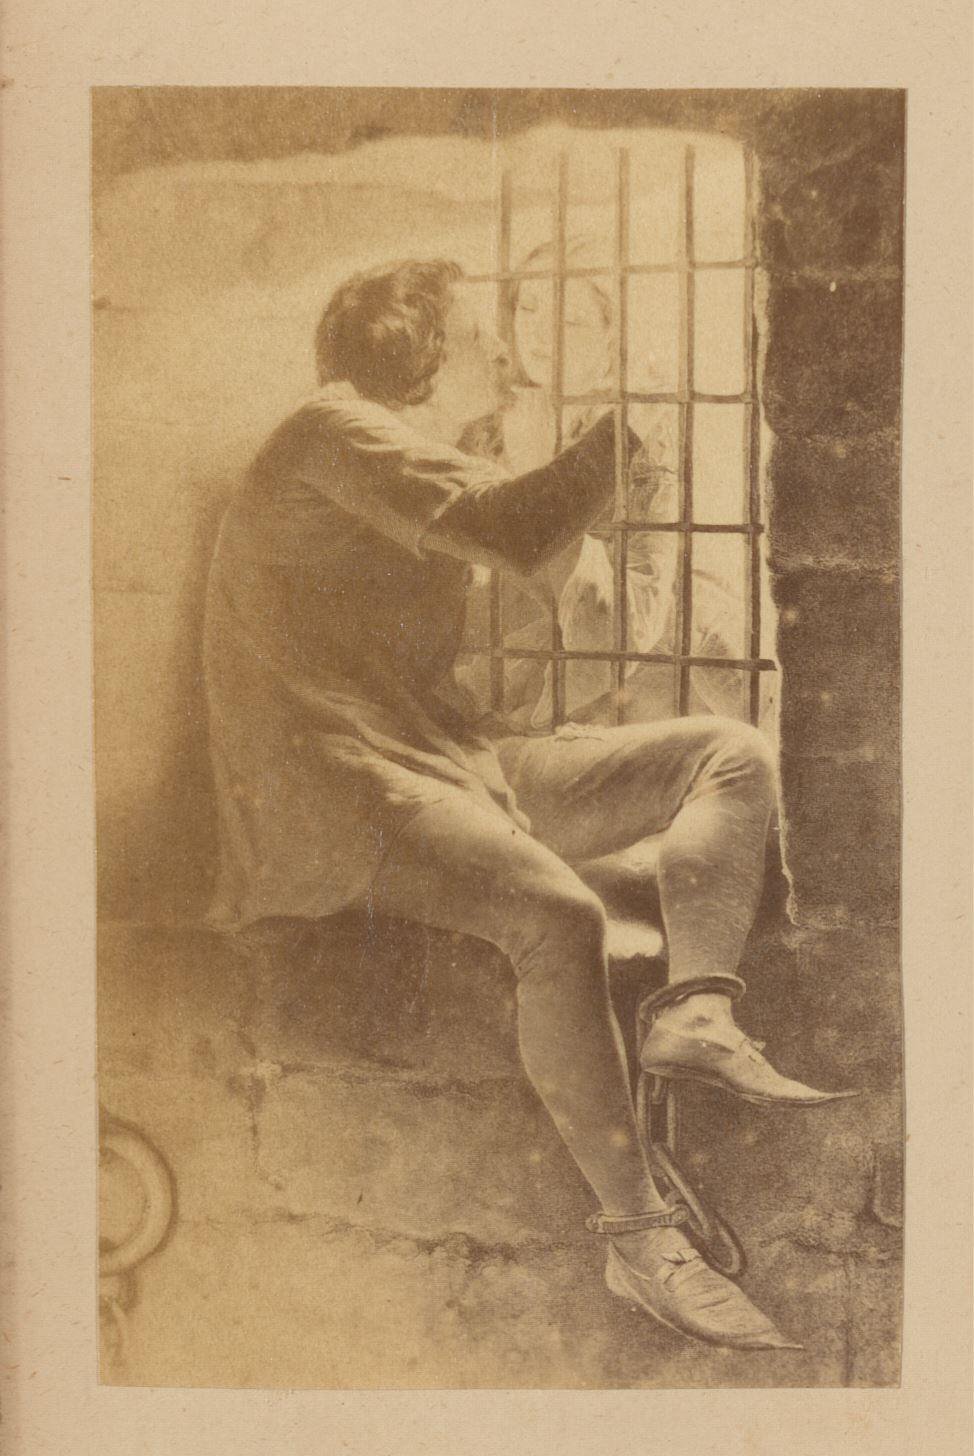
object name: album leaf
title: Fotoreproductie van een schilderij van een geboeide man in het raam van zijn cel, sprekend met een vrouw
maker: Anonymous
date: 1875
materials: photographic support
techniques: albumen print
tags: prisoner; in fetters